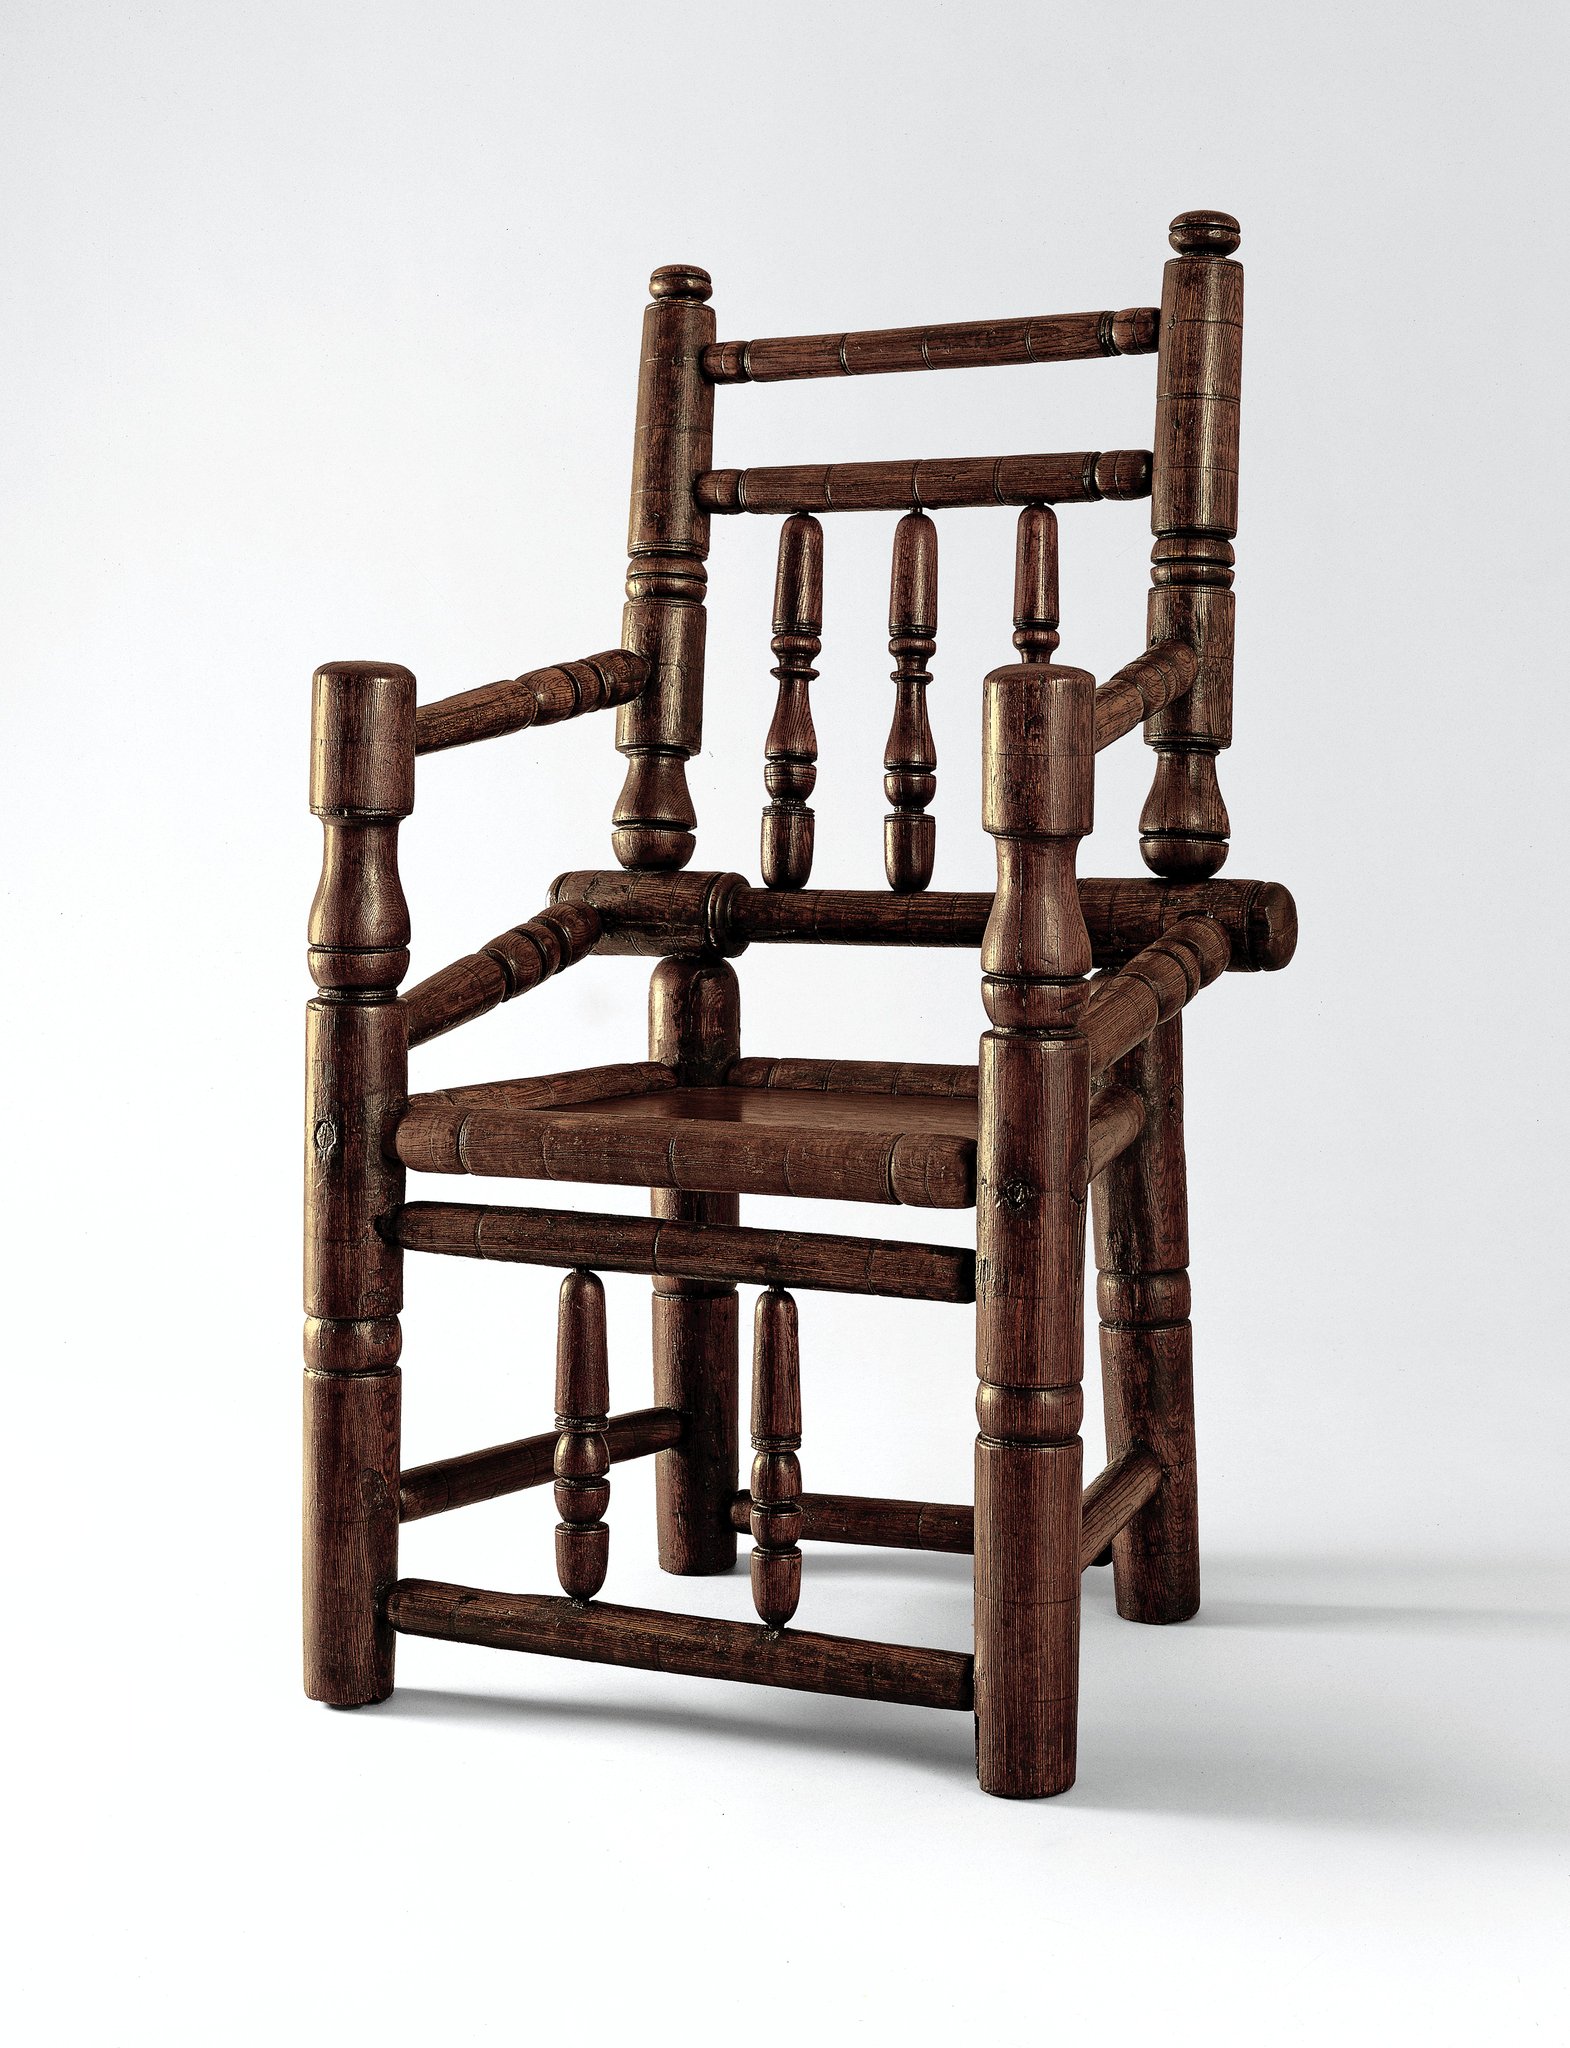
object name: armchair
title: Turned armchair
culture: american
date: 1665-1690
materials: wood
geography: united states